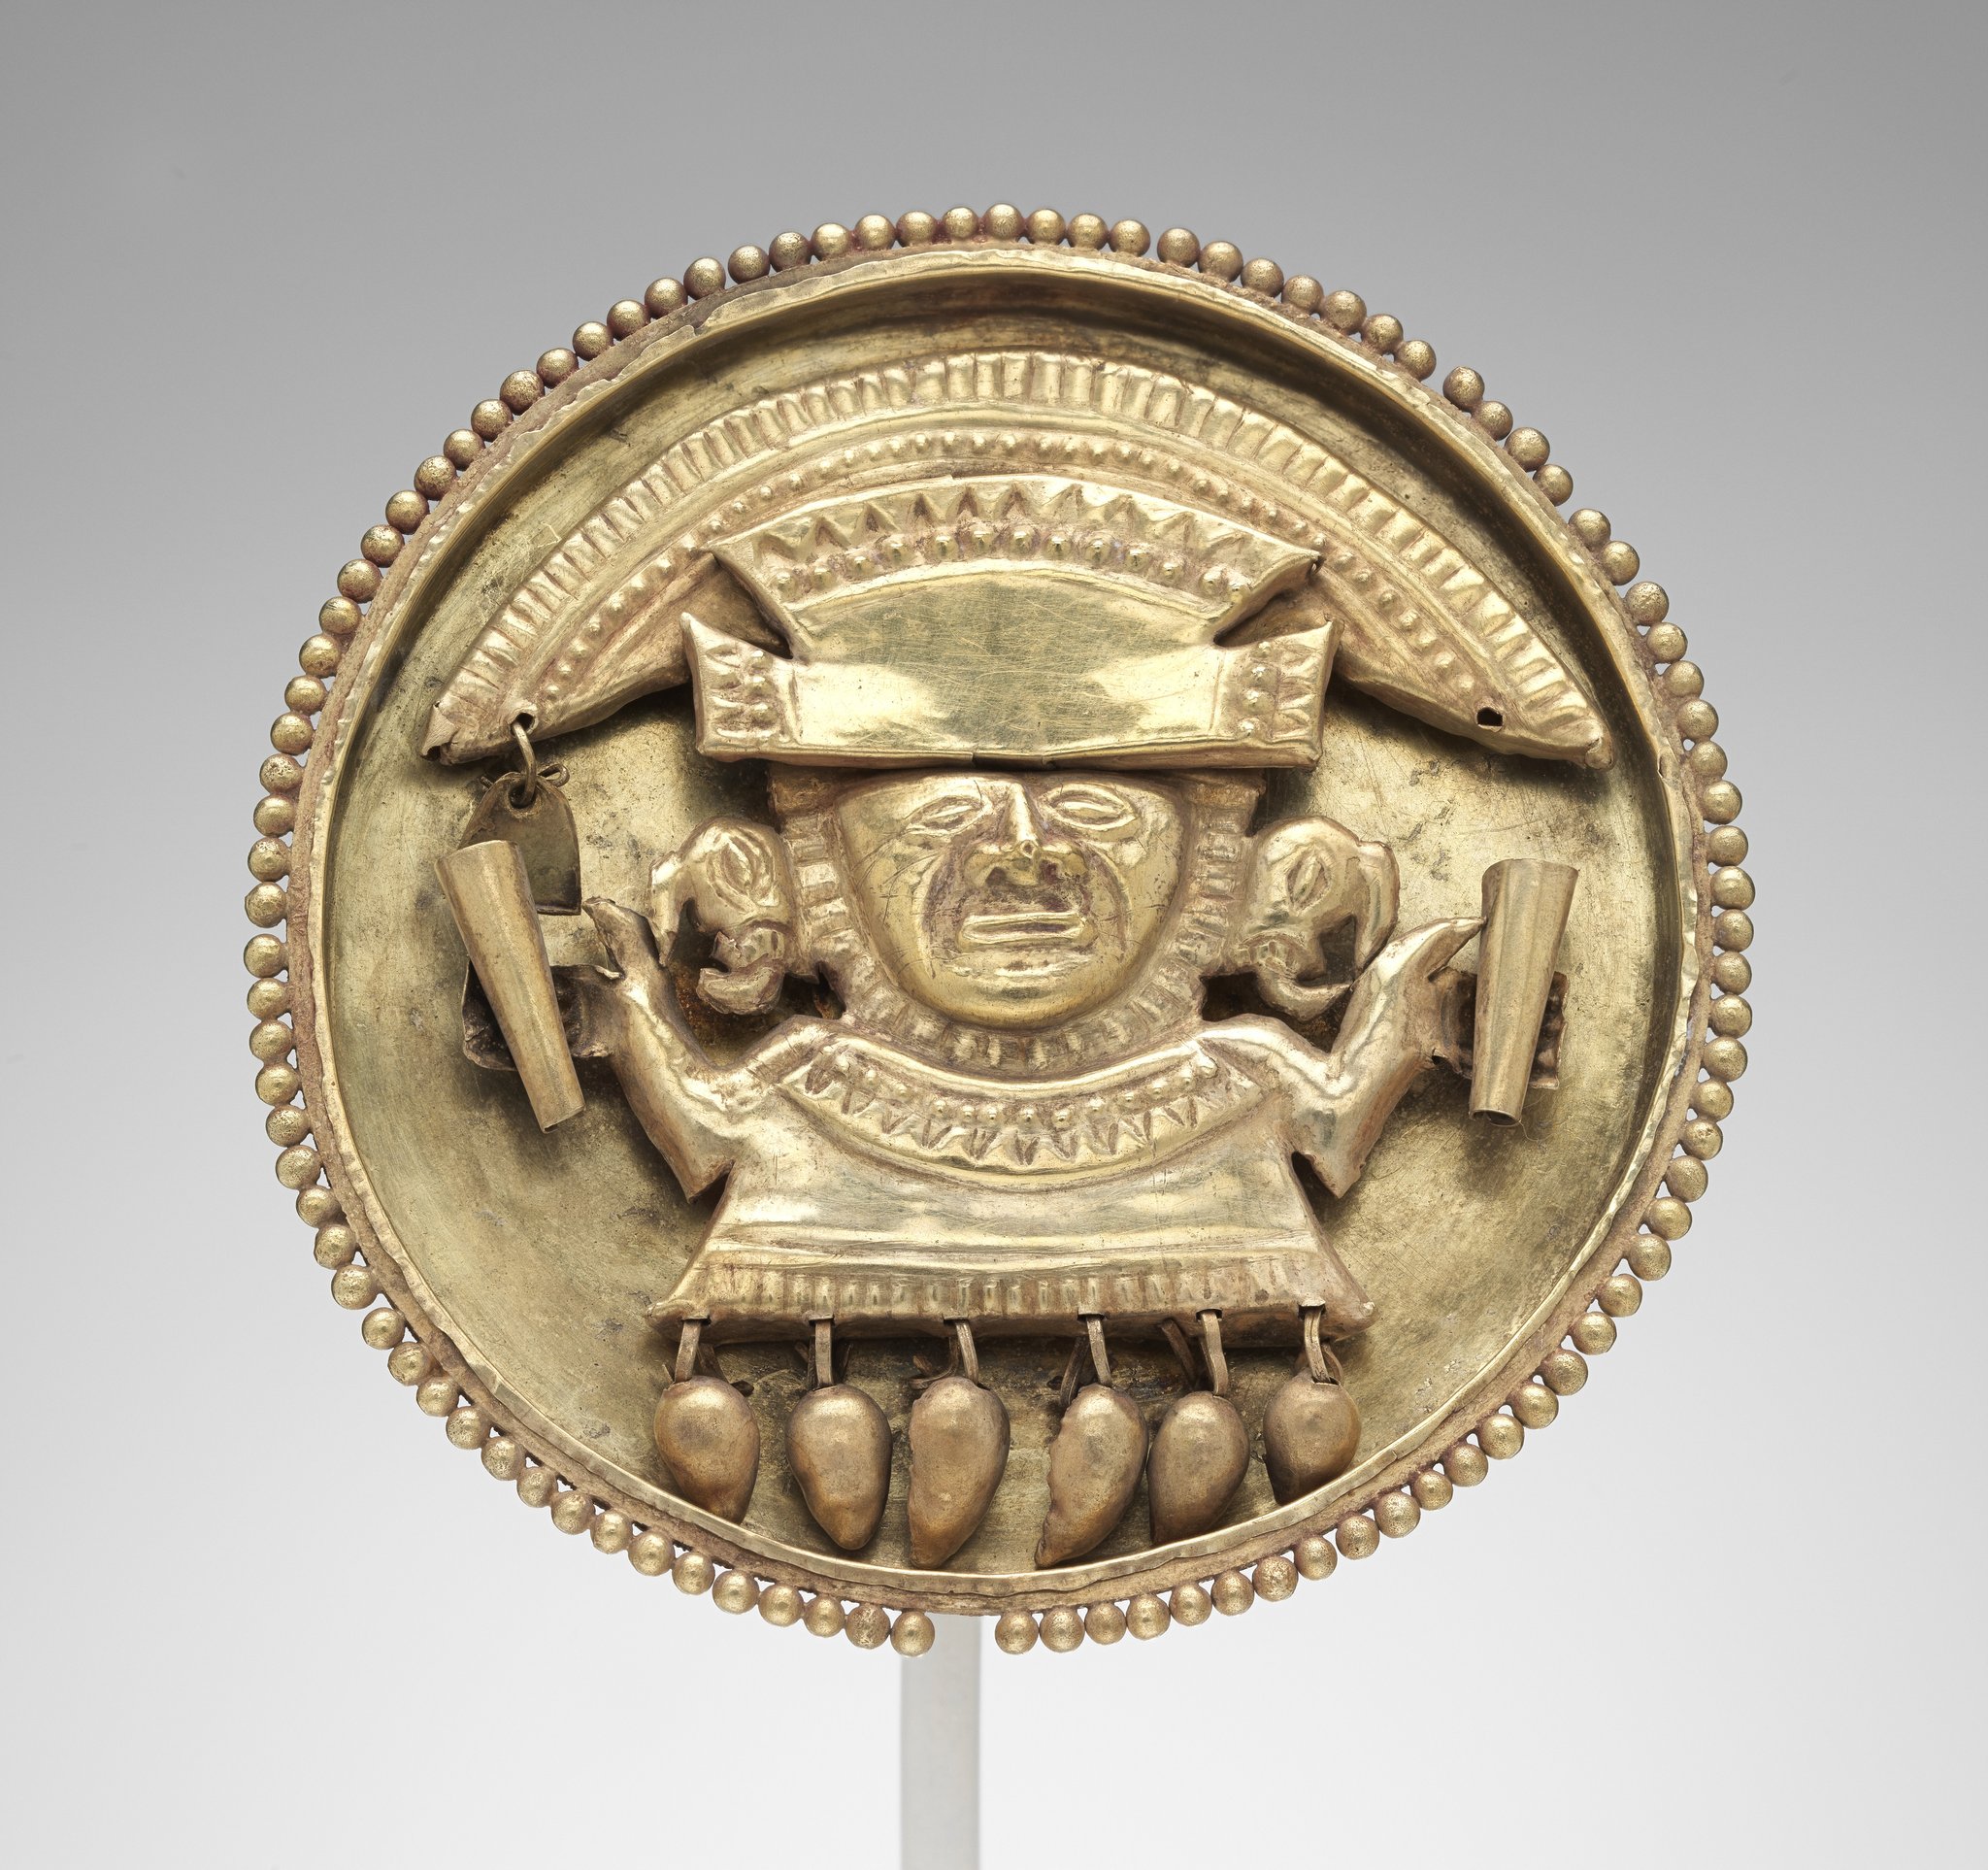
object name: earflare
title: Earflare with figure holding beakers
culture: chimú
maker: chimú artist(s)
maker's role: artist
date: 1350-1470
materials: gold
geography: peru